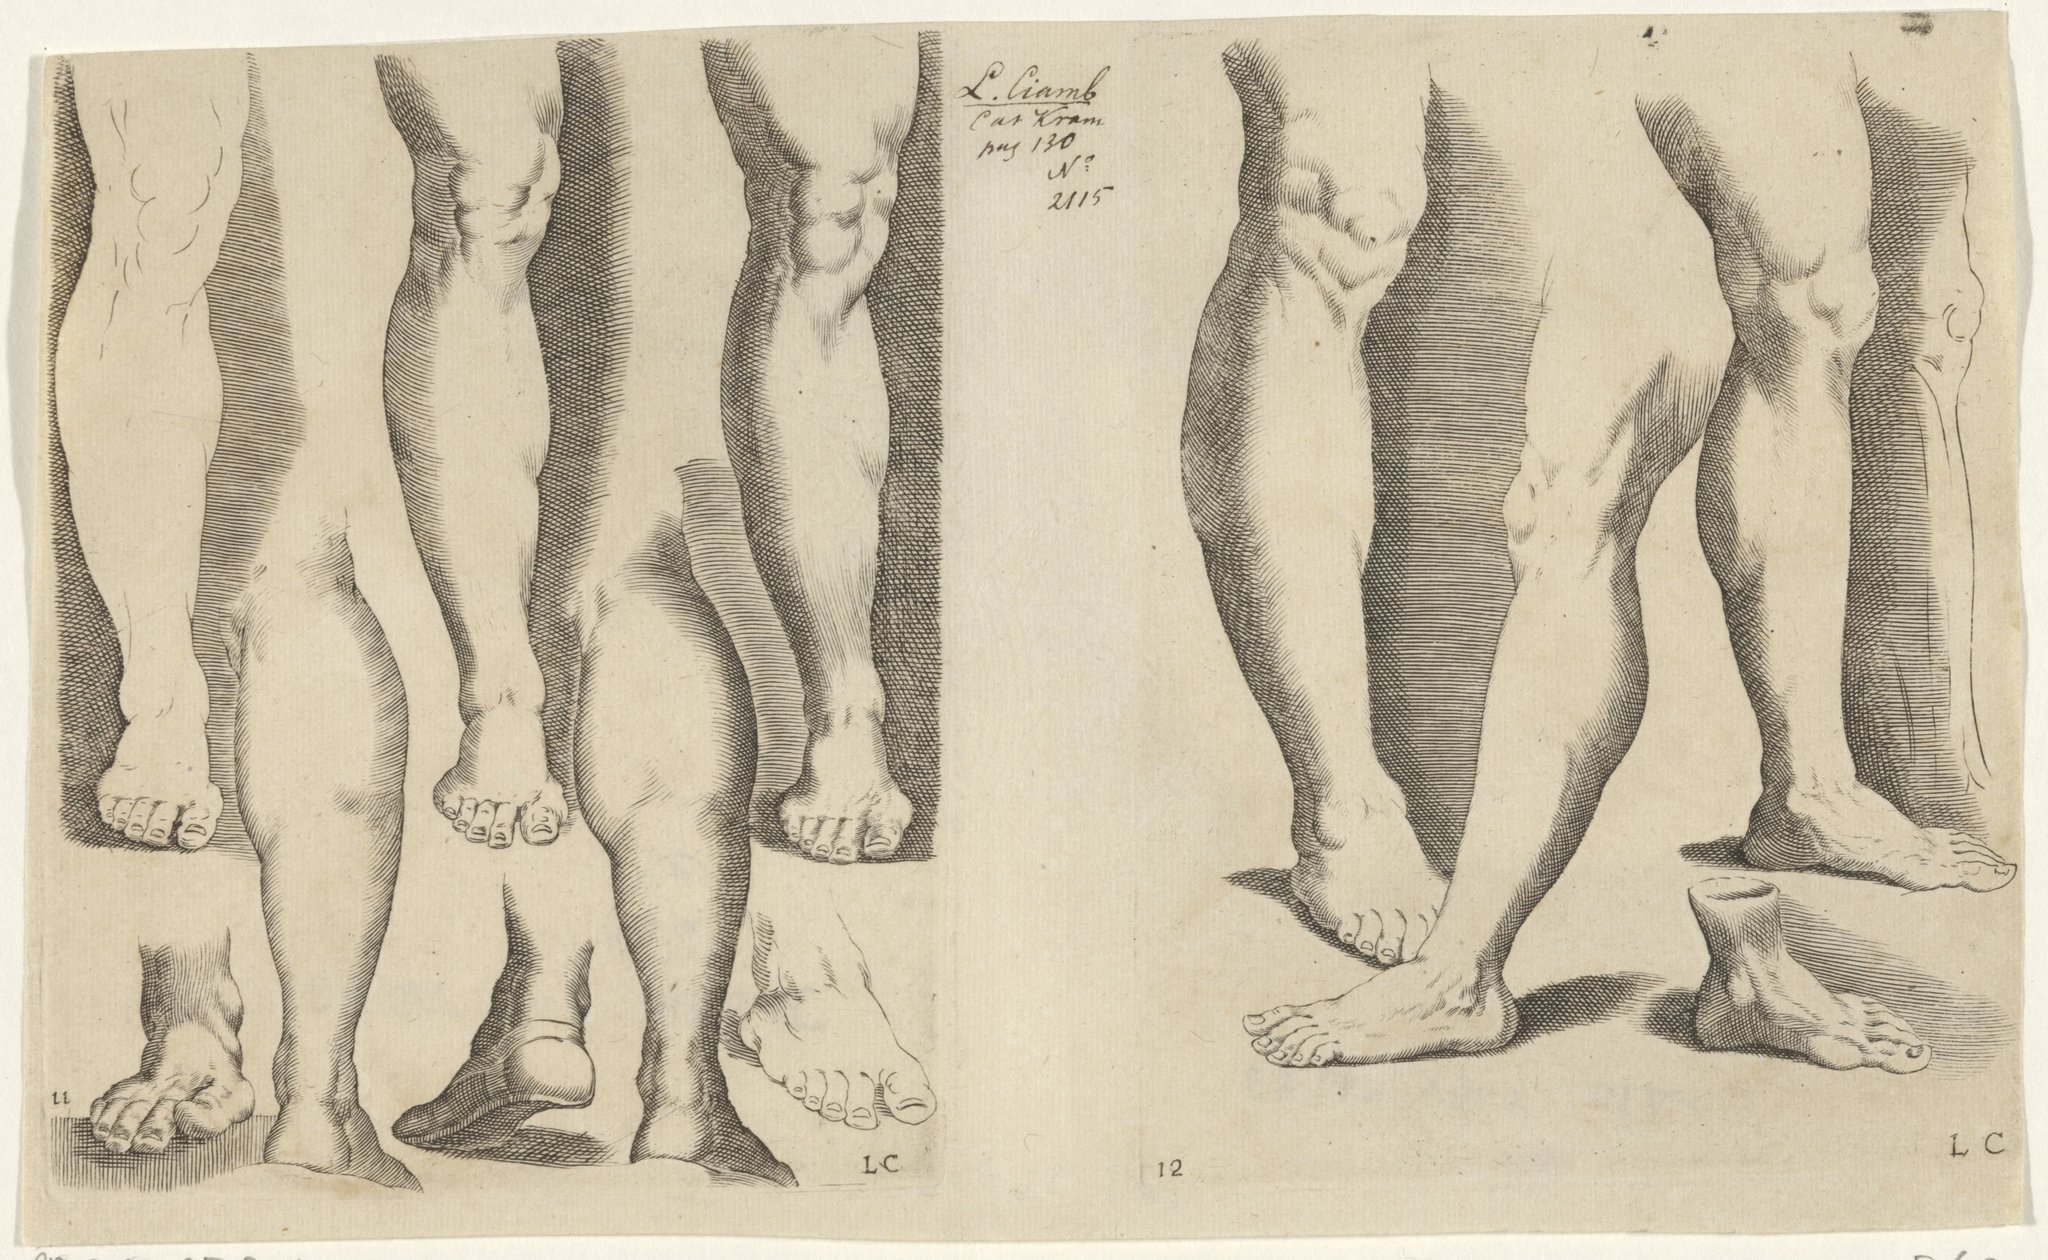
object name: print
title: Tekenboek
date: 1580-1641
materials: paper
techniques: engraving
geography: italy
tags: foot, legs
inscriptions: inscription: ‘L. Ciamb. / Cat Kram / [...] 130 / No / 2115’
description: Blad met twee voorstellingen. Links: drie benen van voren gezien, twee benen van achteren gezien en drie voeten. Rechts: drie benen en een voet. Linker voorstelling genummerd linksonder: 11. Rechter voorstelling genummerd linksonder: 12.